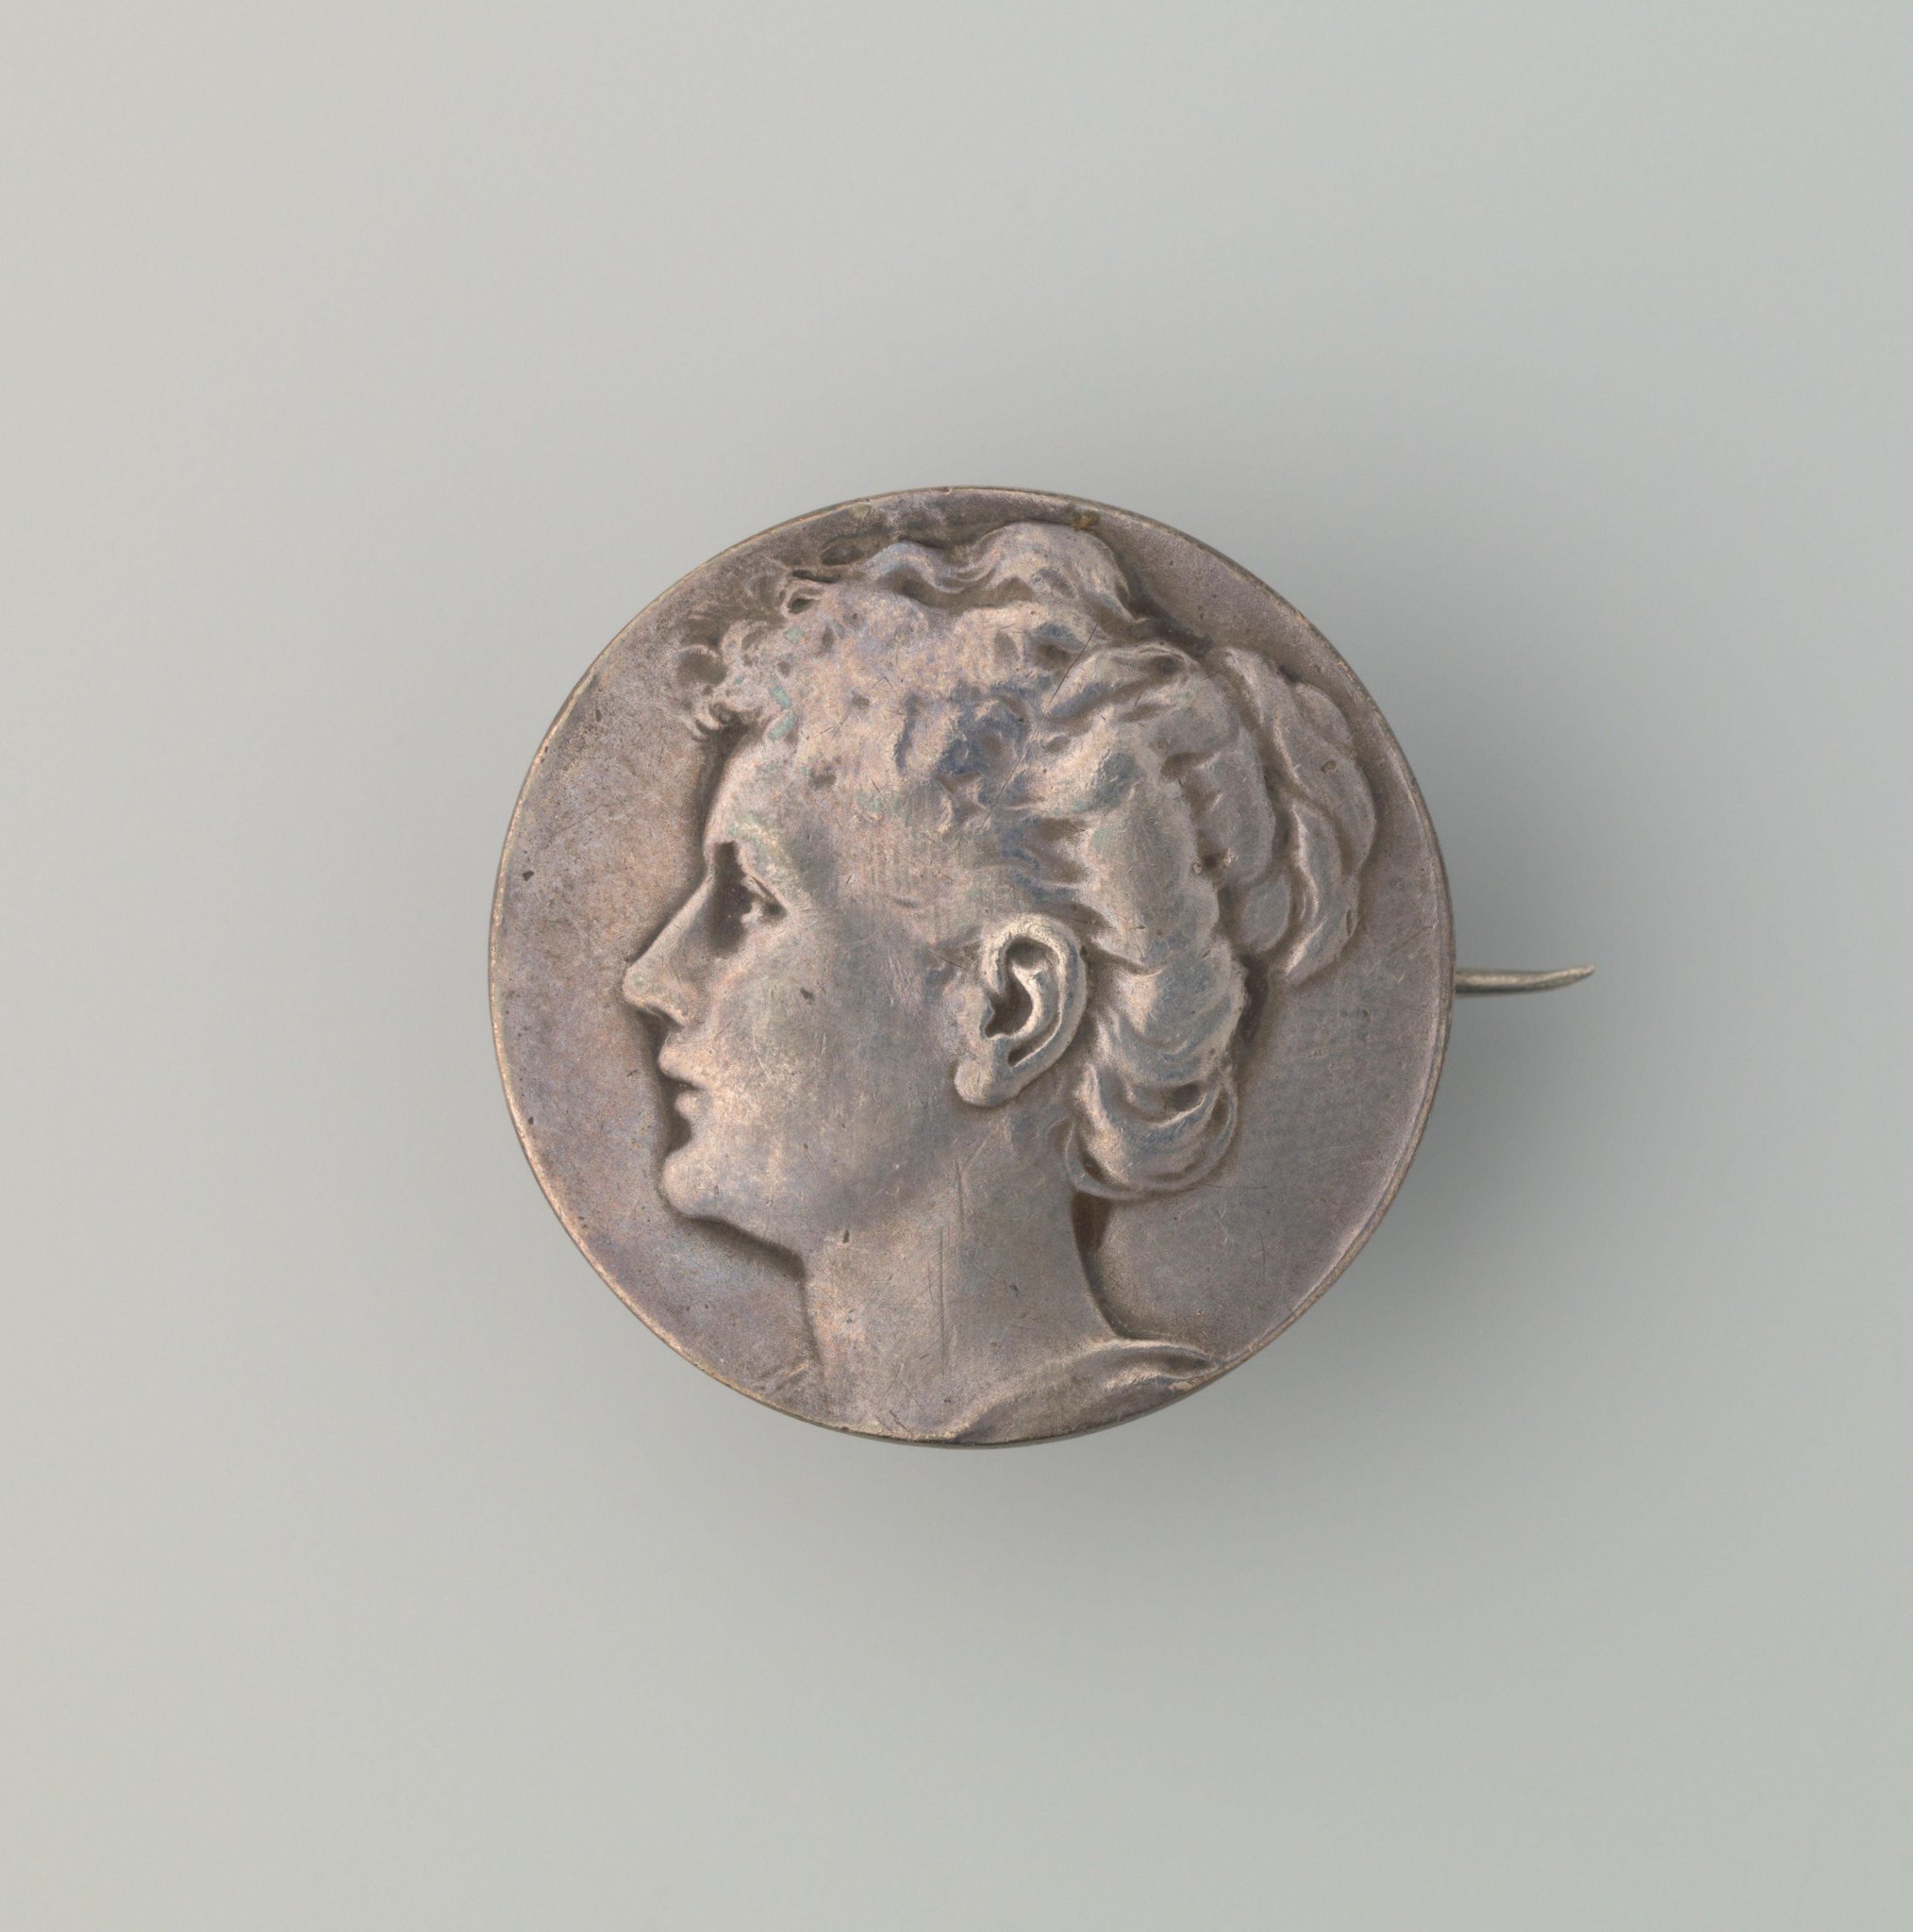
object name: brooch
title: Zilveren broche van Wilhelmina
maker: Anonymous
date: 1900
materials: silver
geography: dutch east indies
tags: print maker, wilhelmina of the netherlands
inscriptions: : ‘900’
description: Zilveren broche van Wilhelmina en profil naar links gewend, voorzien van een haaksluiting.